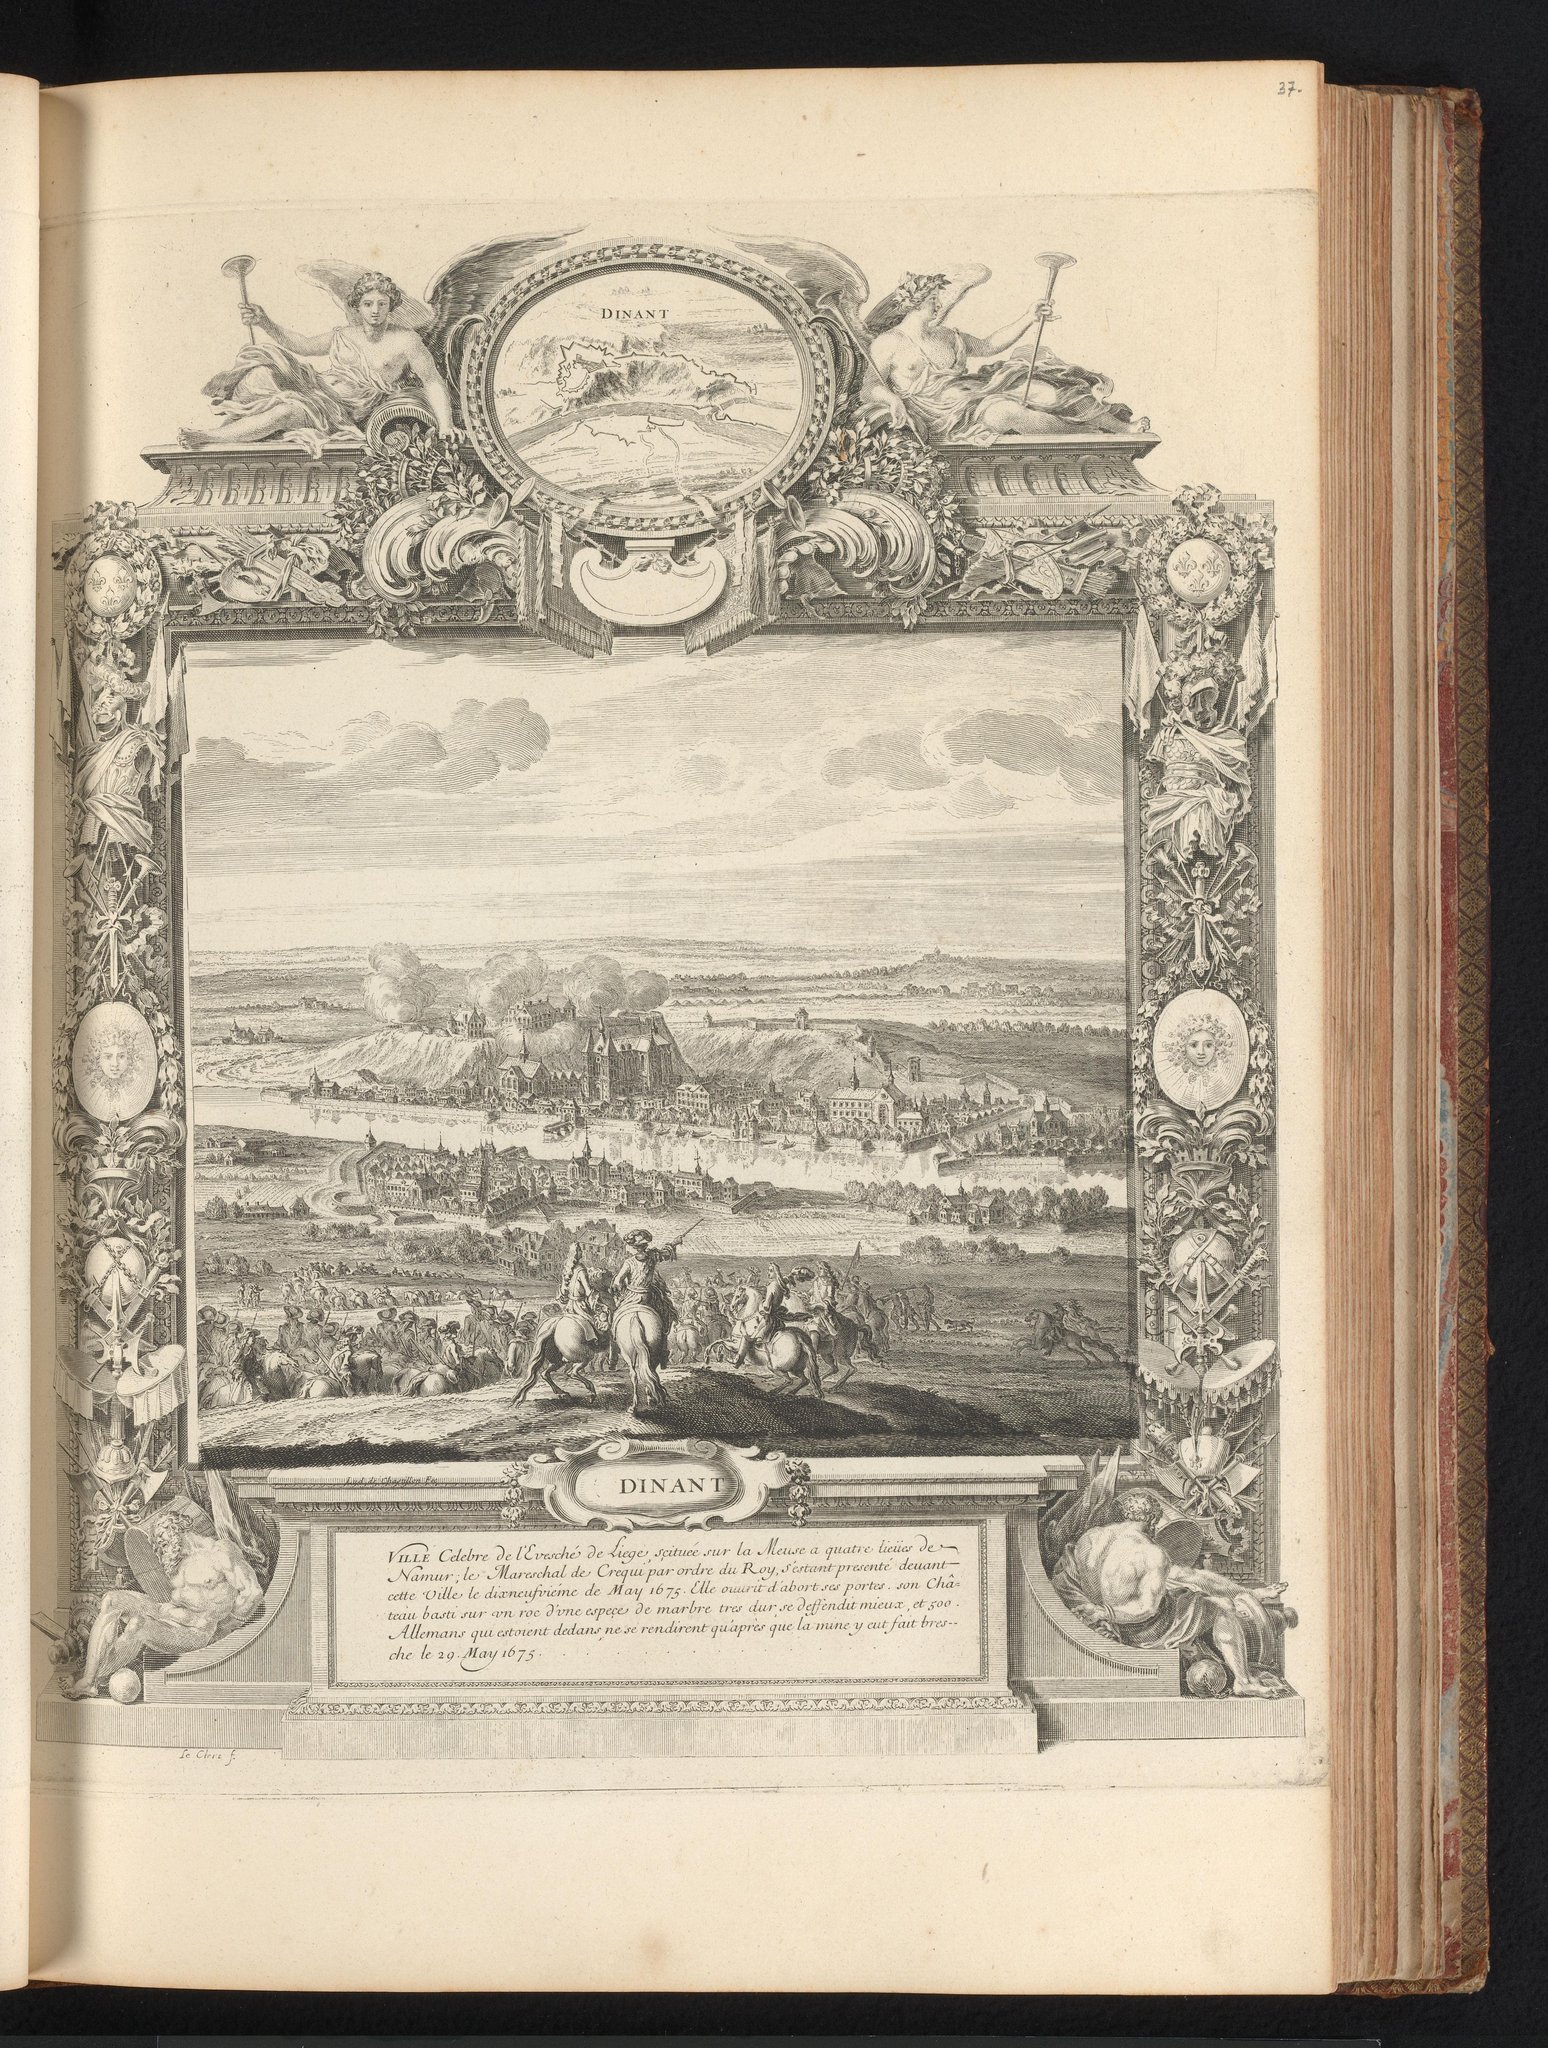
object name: album leaf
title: Dinant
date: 1686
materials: paper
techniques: engraving, etching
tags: battle, capture of city (after the siege)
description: Maakt deel uit van een serie bestaande uit 28 prenten met oorlogstaferelen in ornamentele cartouches. De prenten zijn gedrukt van twee afzonderlijke platen bestaande uit de voorstelling en de cartouche.